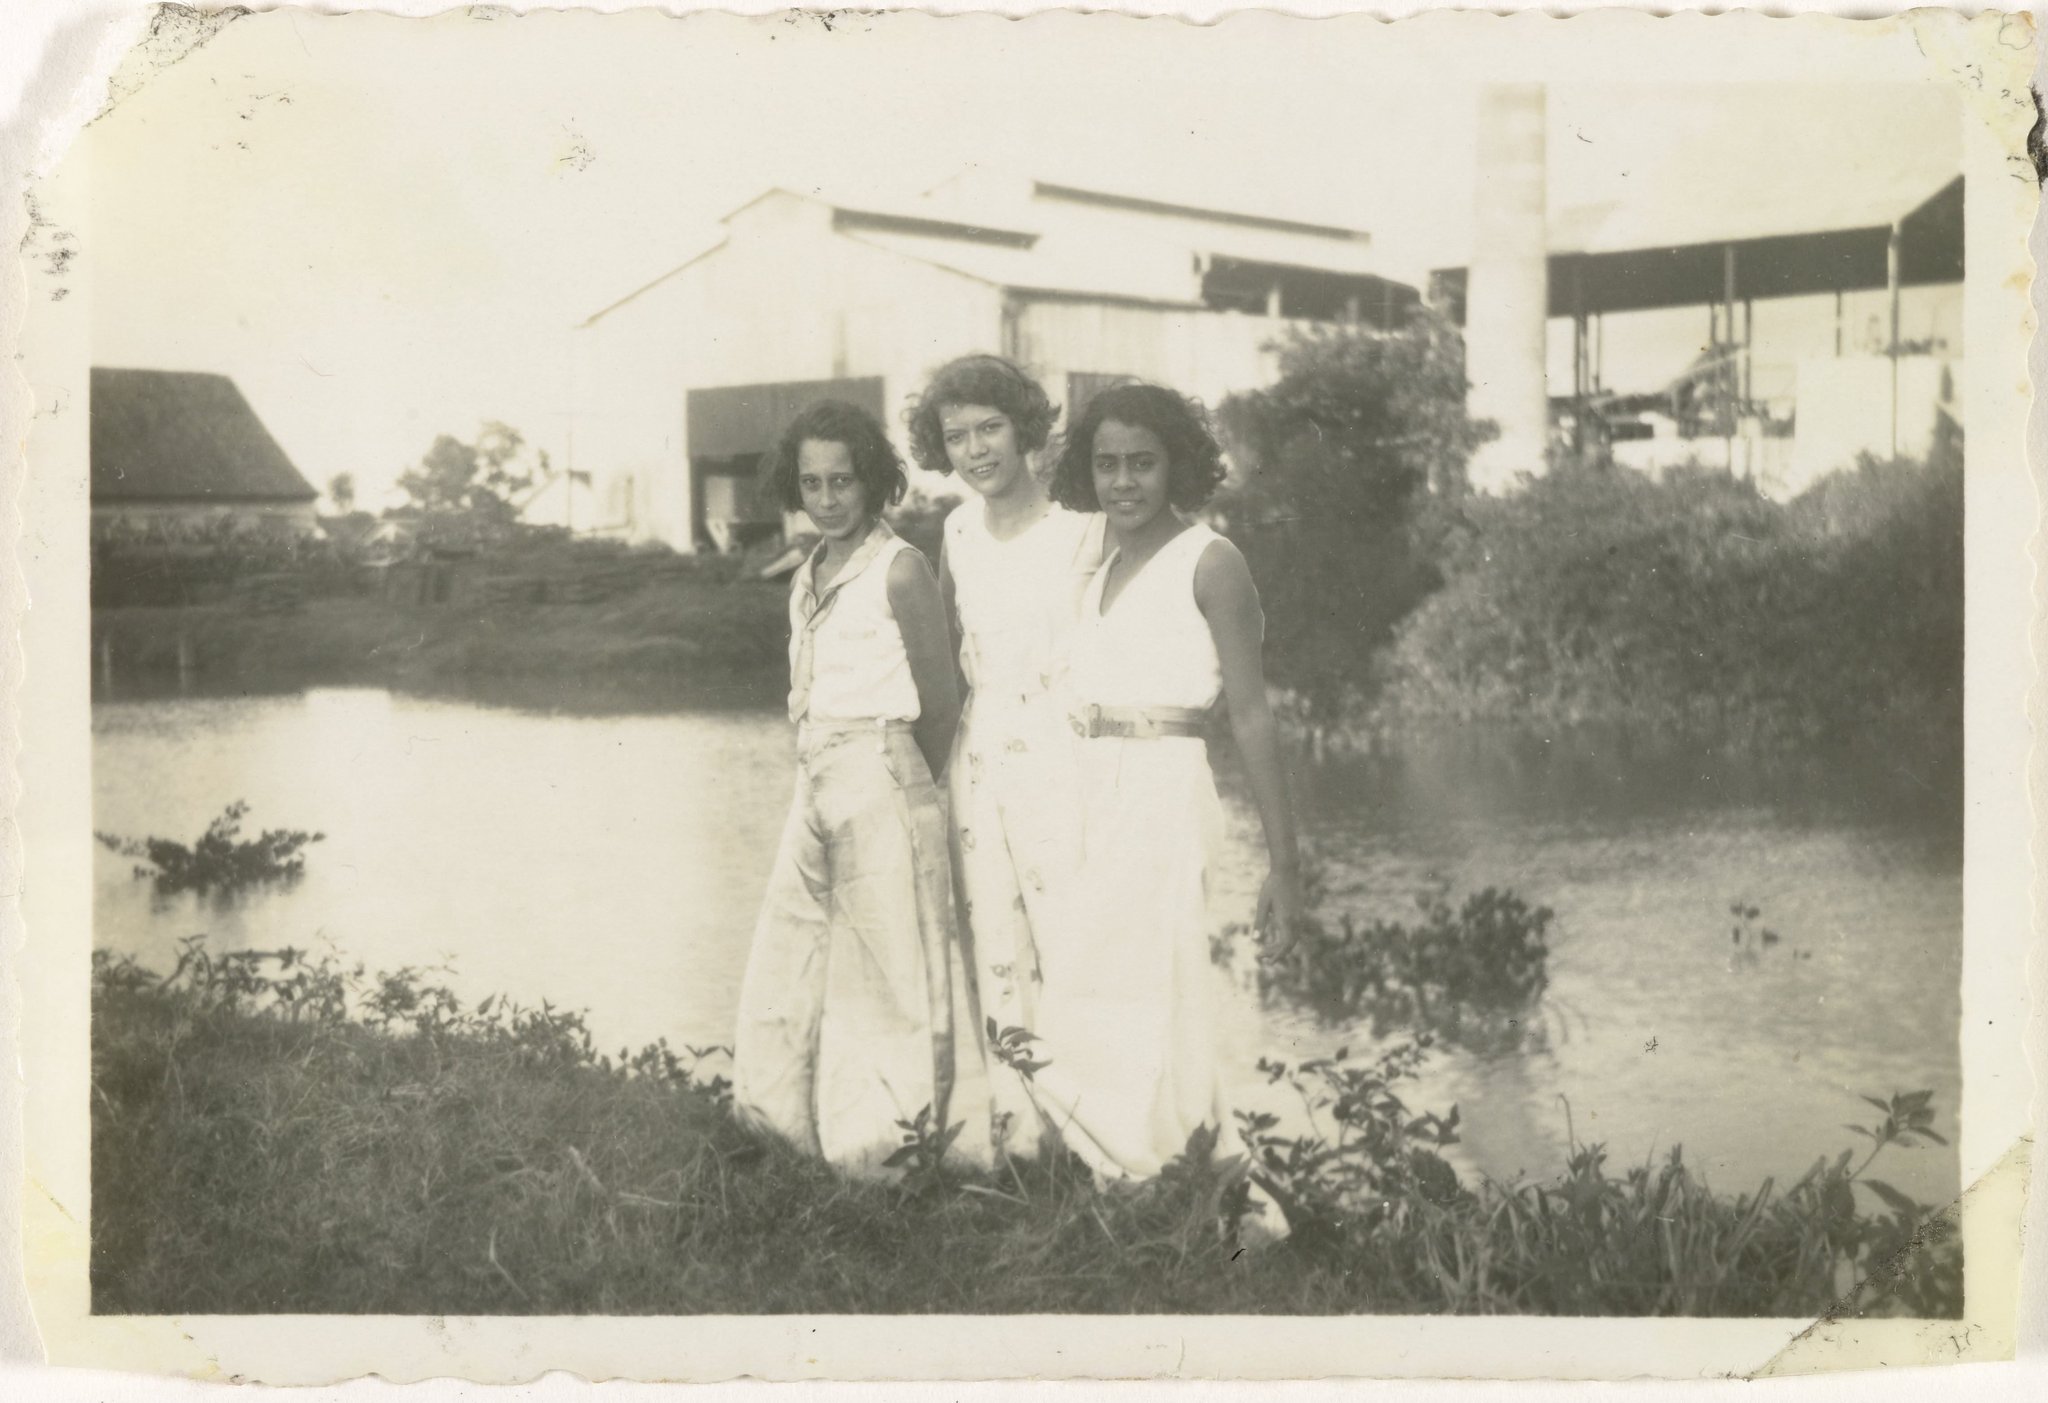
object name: photograph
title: Plantage Rust en Werk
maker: Anonymous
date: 1928-1932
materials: photographic support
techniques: photography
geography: suriname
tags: amsterdam, theodoor brouwers, suriname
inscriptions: inscription: ‘Rust en Werk’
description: In de periode 1911-1932 woonde op plantage Accaribo in Suriname de familie Brouwers van wie de foto's afkomstig zijn. Rond 1910 vond Theodoor Brouwers werk op plantage Accaribo. In 1929 werd hij eigenaar van de plantage.